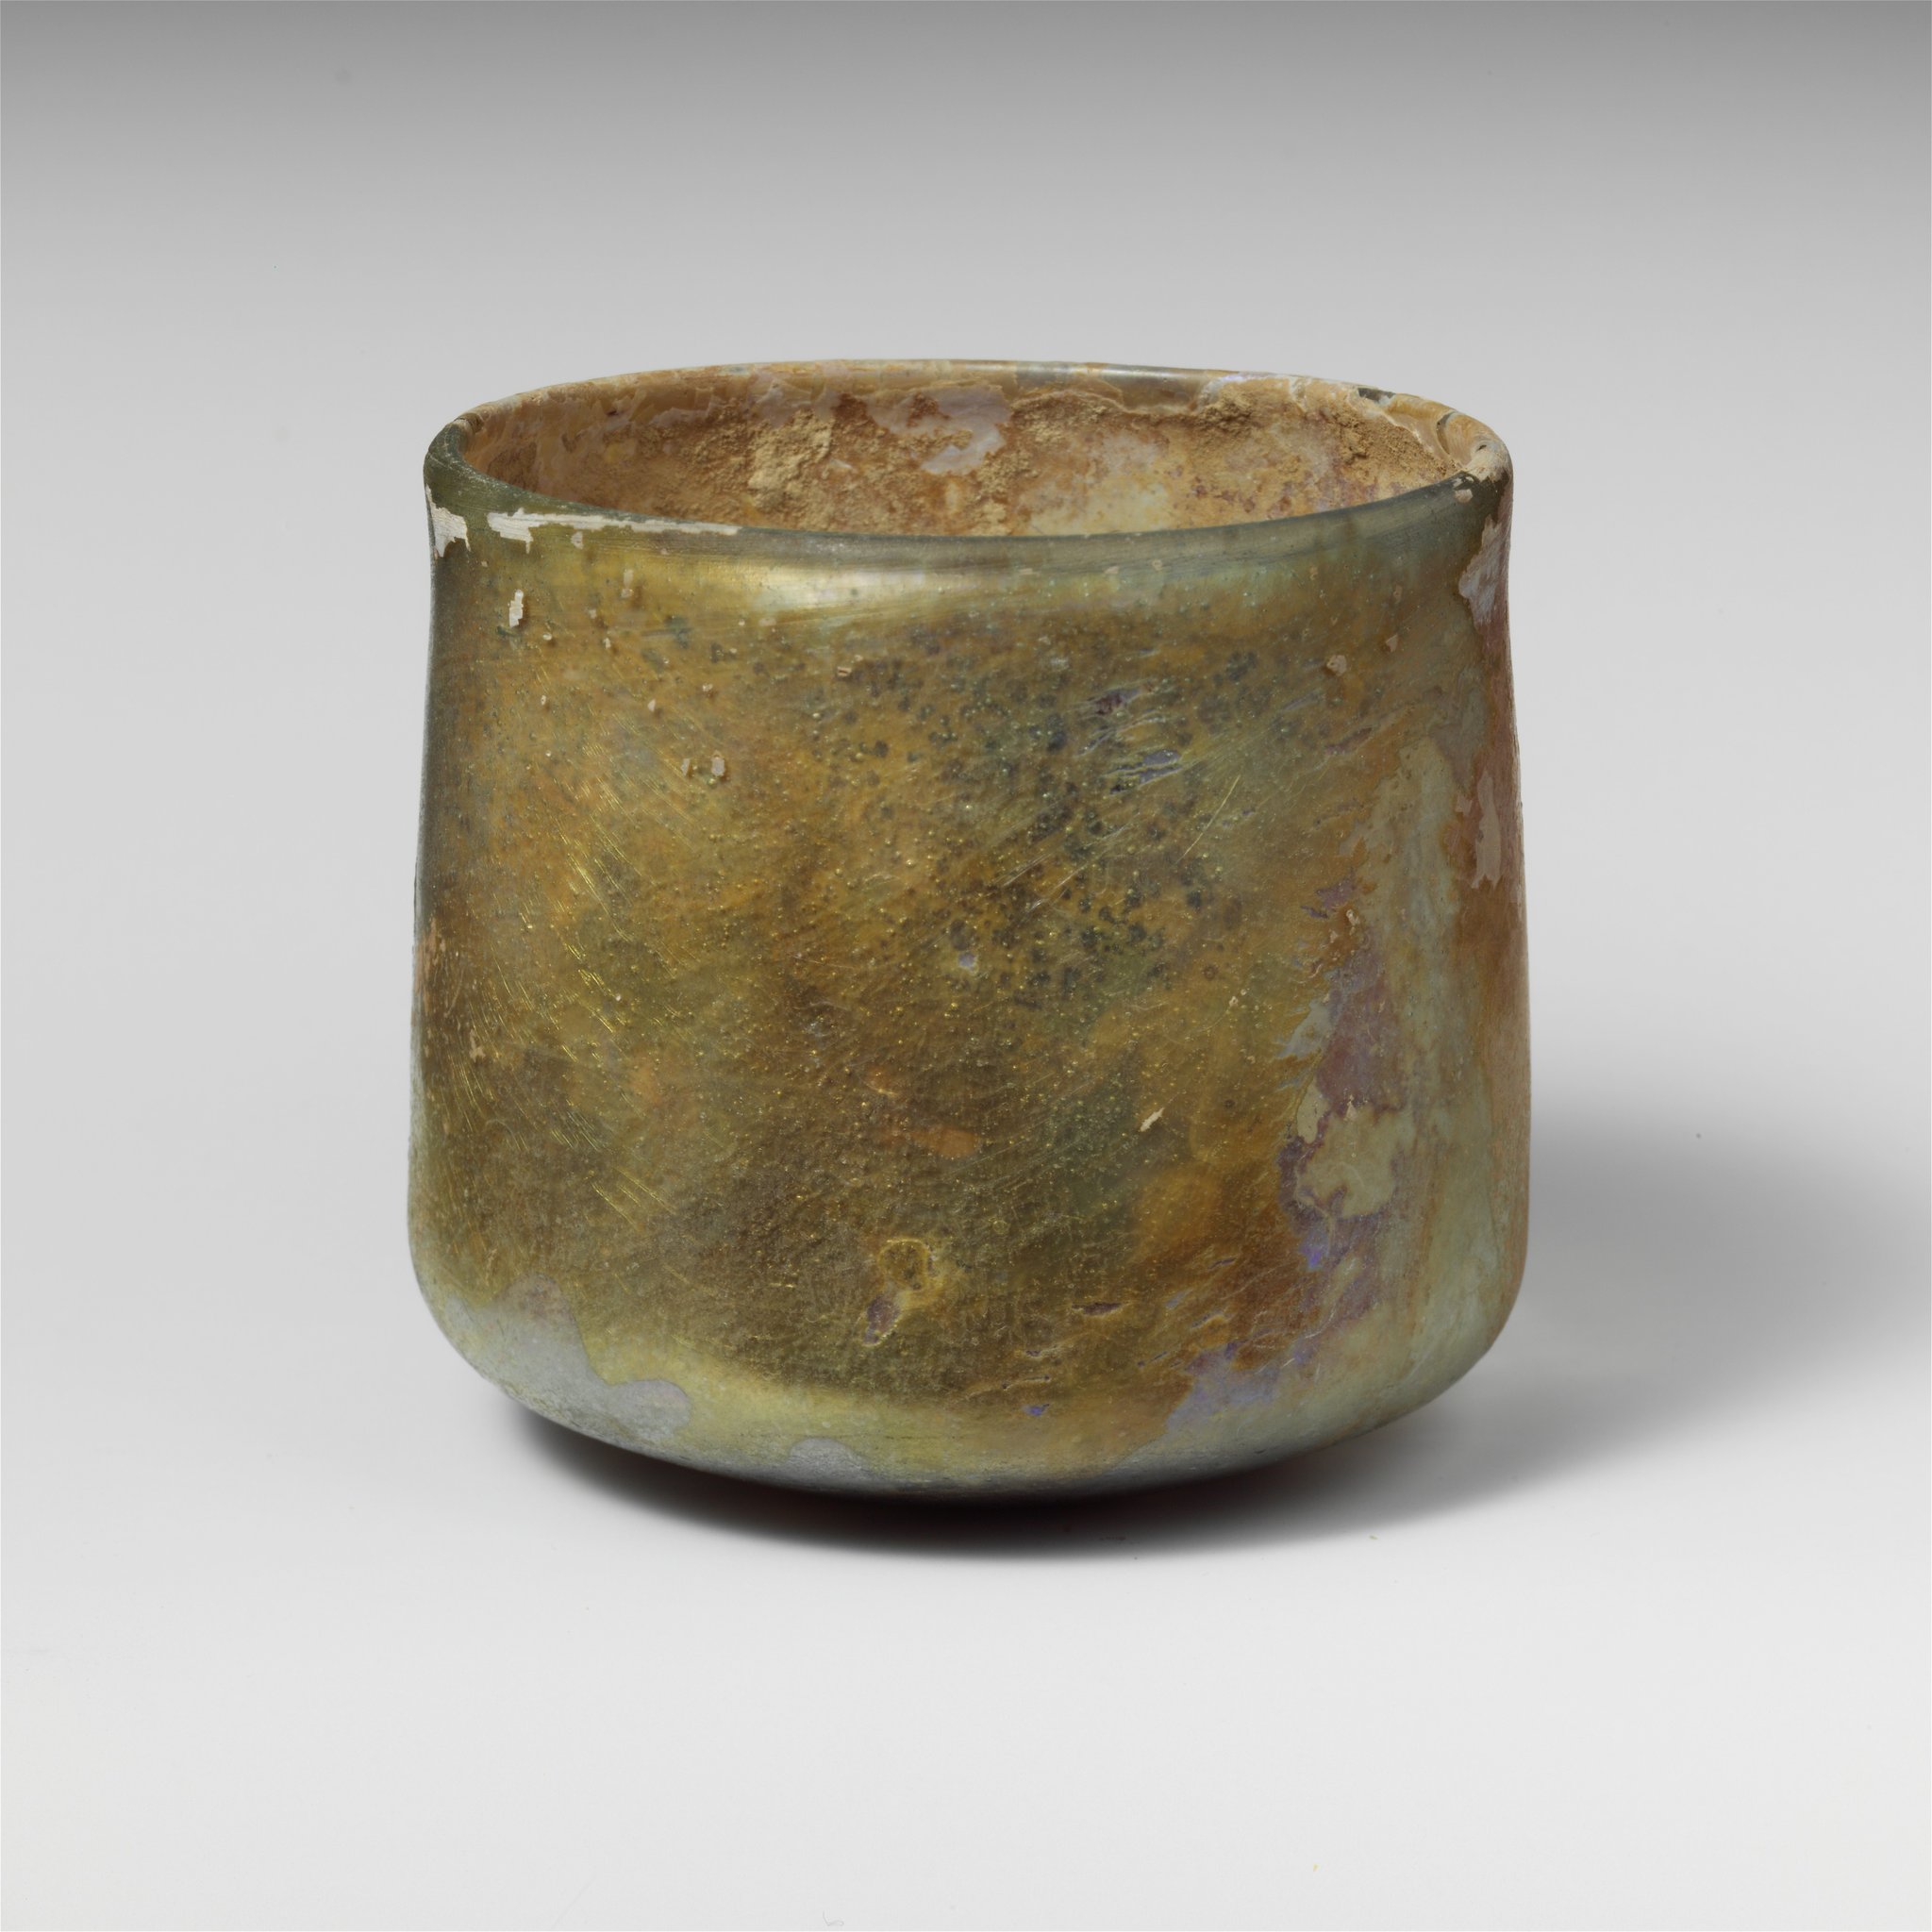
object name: cup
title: Glass beaker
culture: roman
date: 101-300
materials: glass